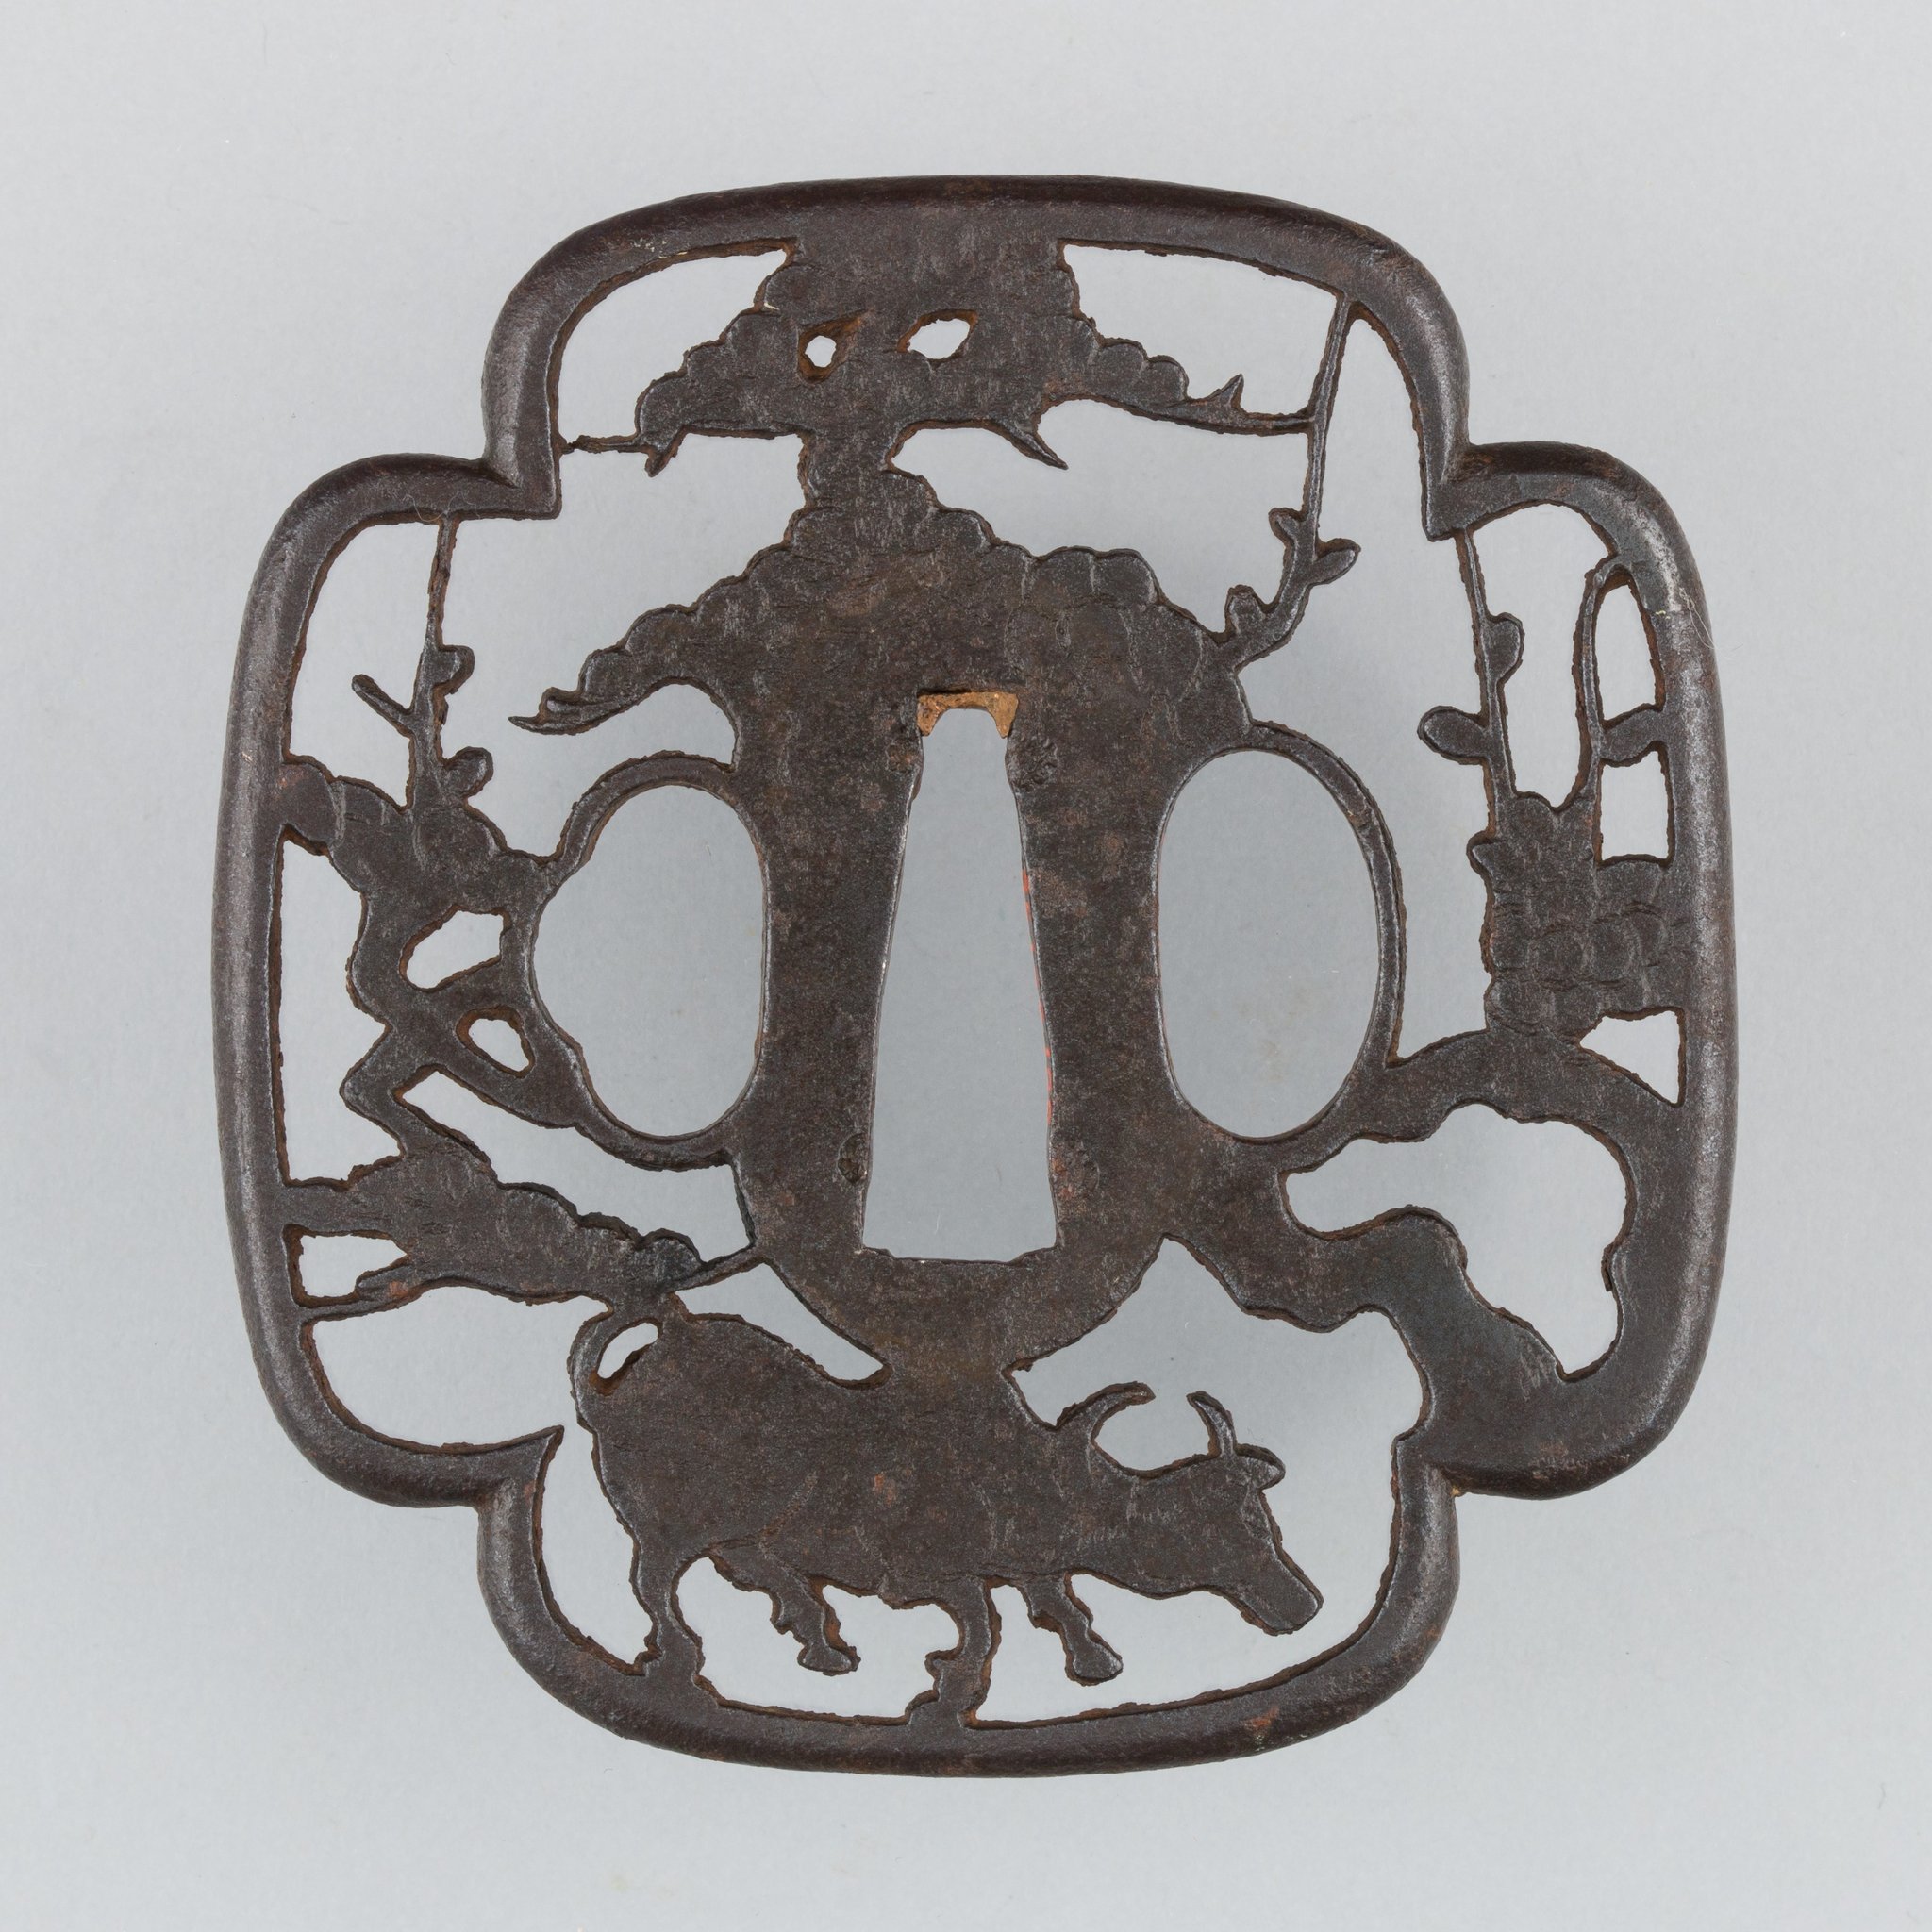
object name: sword guard tsuba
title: Sword Guard (Tsuba)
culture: japanese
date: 1600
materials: copper, iron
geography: japan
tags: human figures,ox